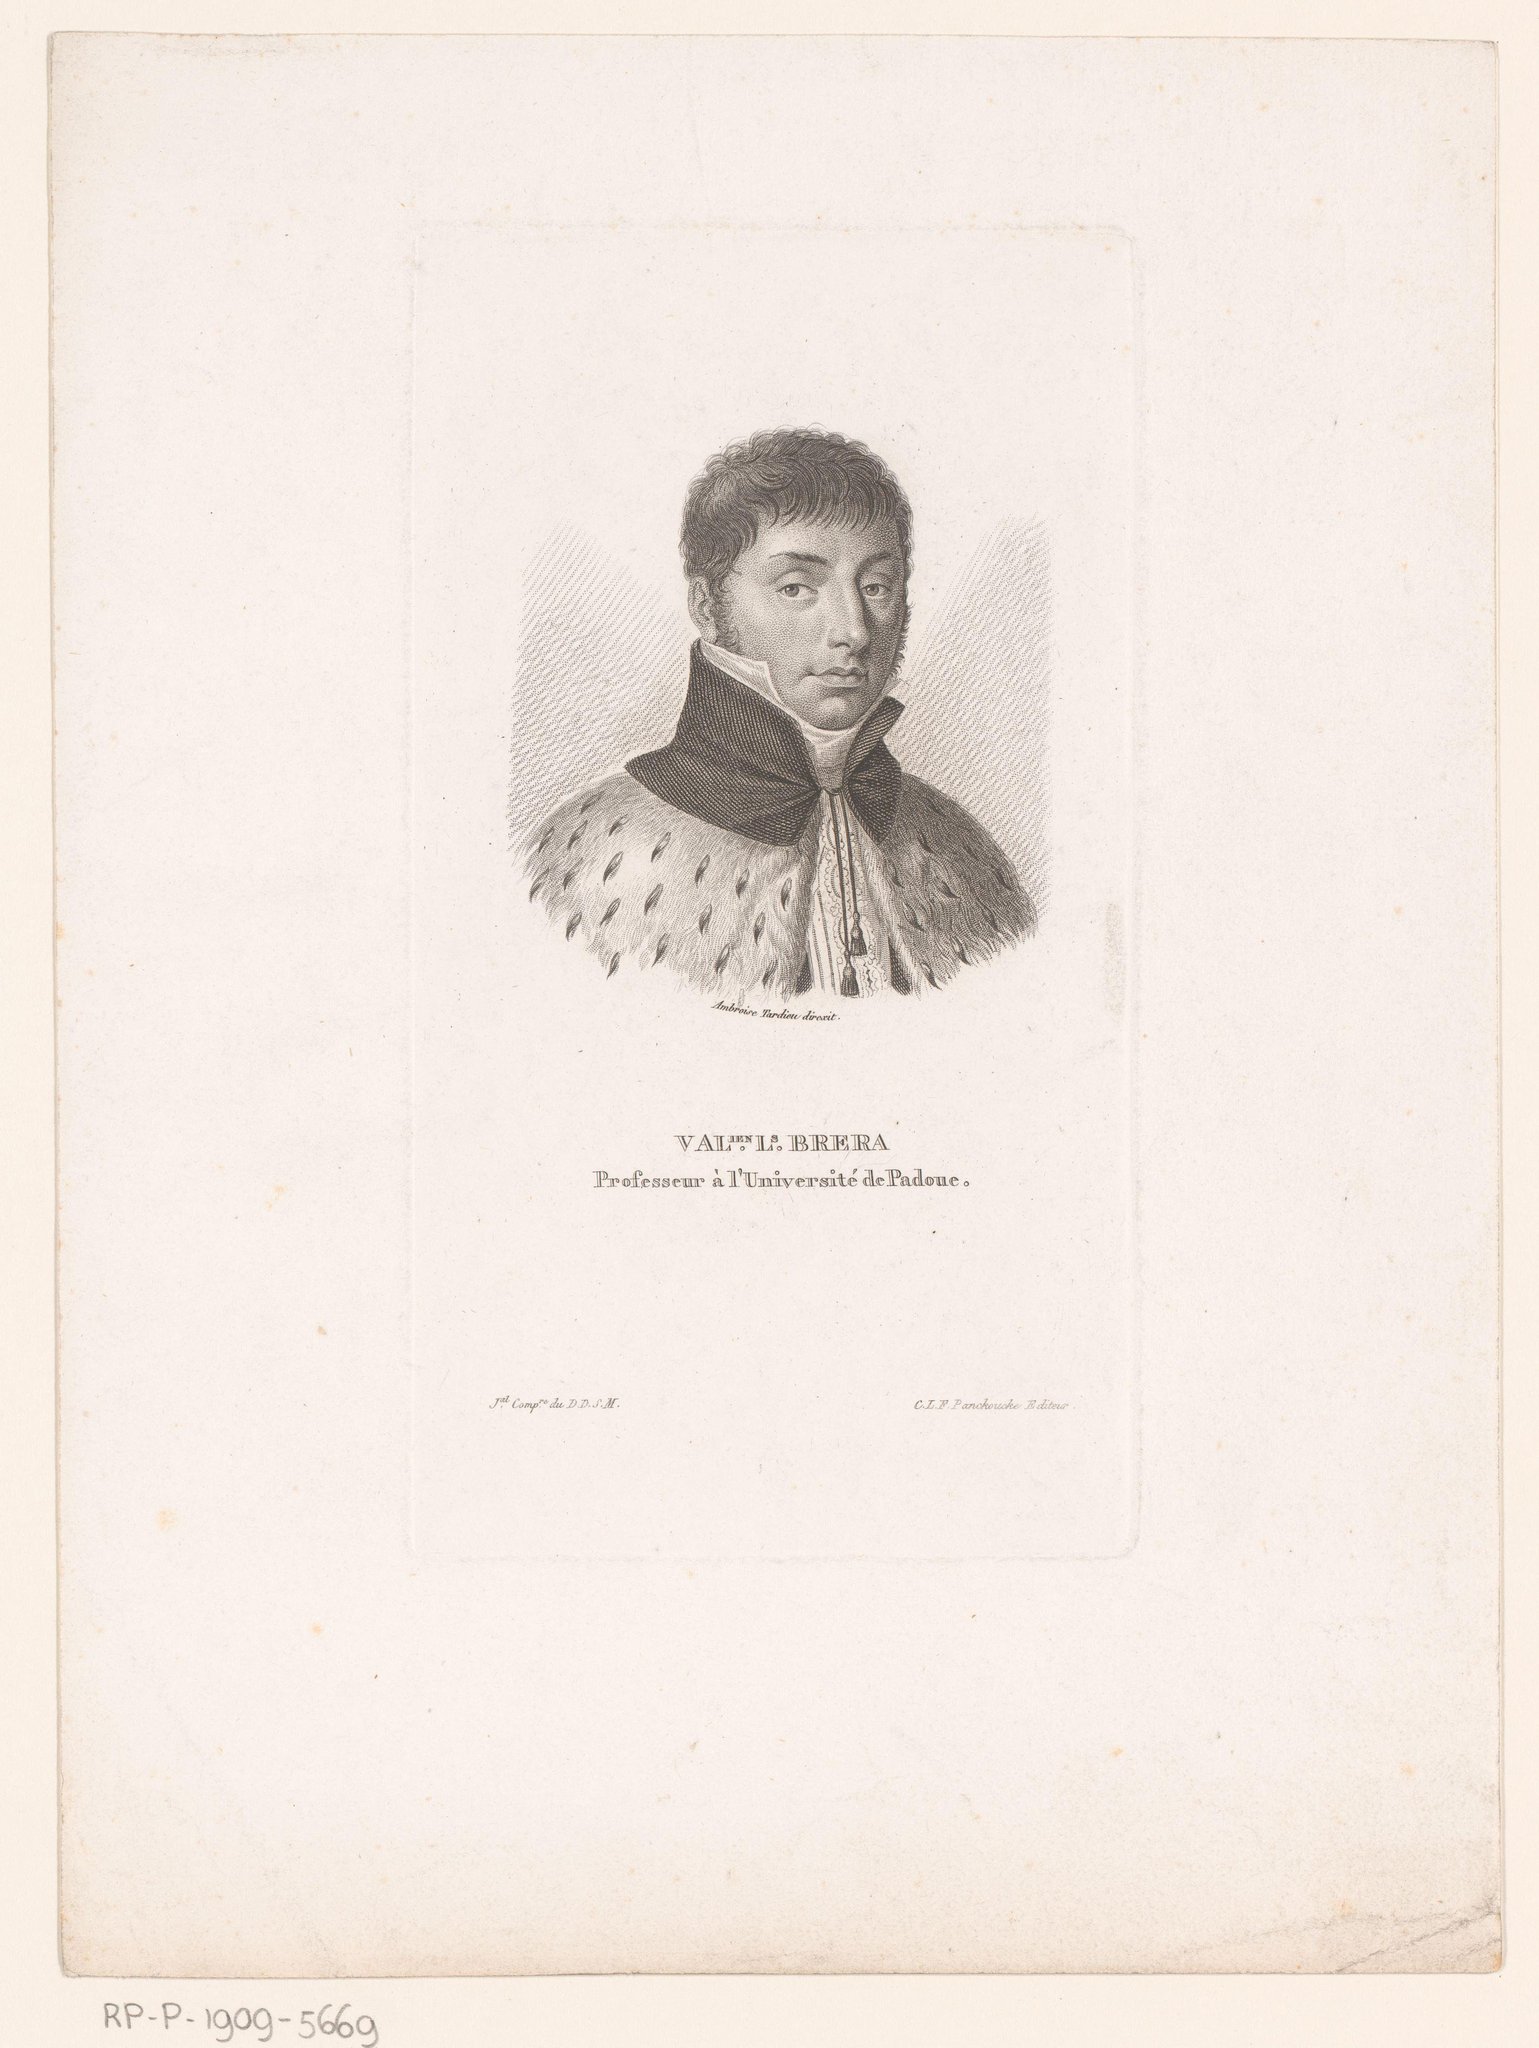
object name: print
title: Portret van Valeriano Luigi Brera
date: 1818-1832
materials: paper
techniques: engraving, roulette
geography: paris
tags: venice, historical persons, physician, doctor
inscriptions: collector's mark: Lugt 2228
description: Prent uit: Journal complémentaire du Dictionnaire des sciences médicales. Parijs: Panckoucke, Charles Louis Fleury, 1818-1832.